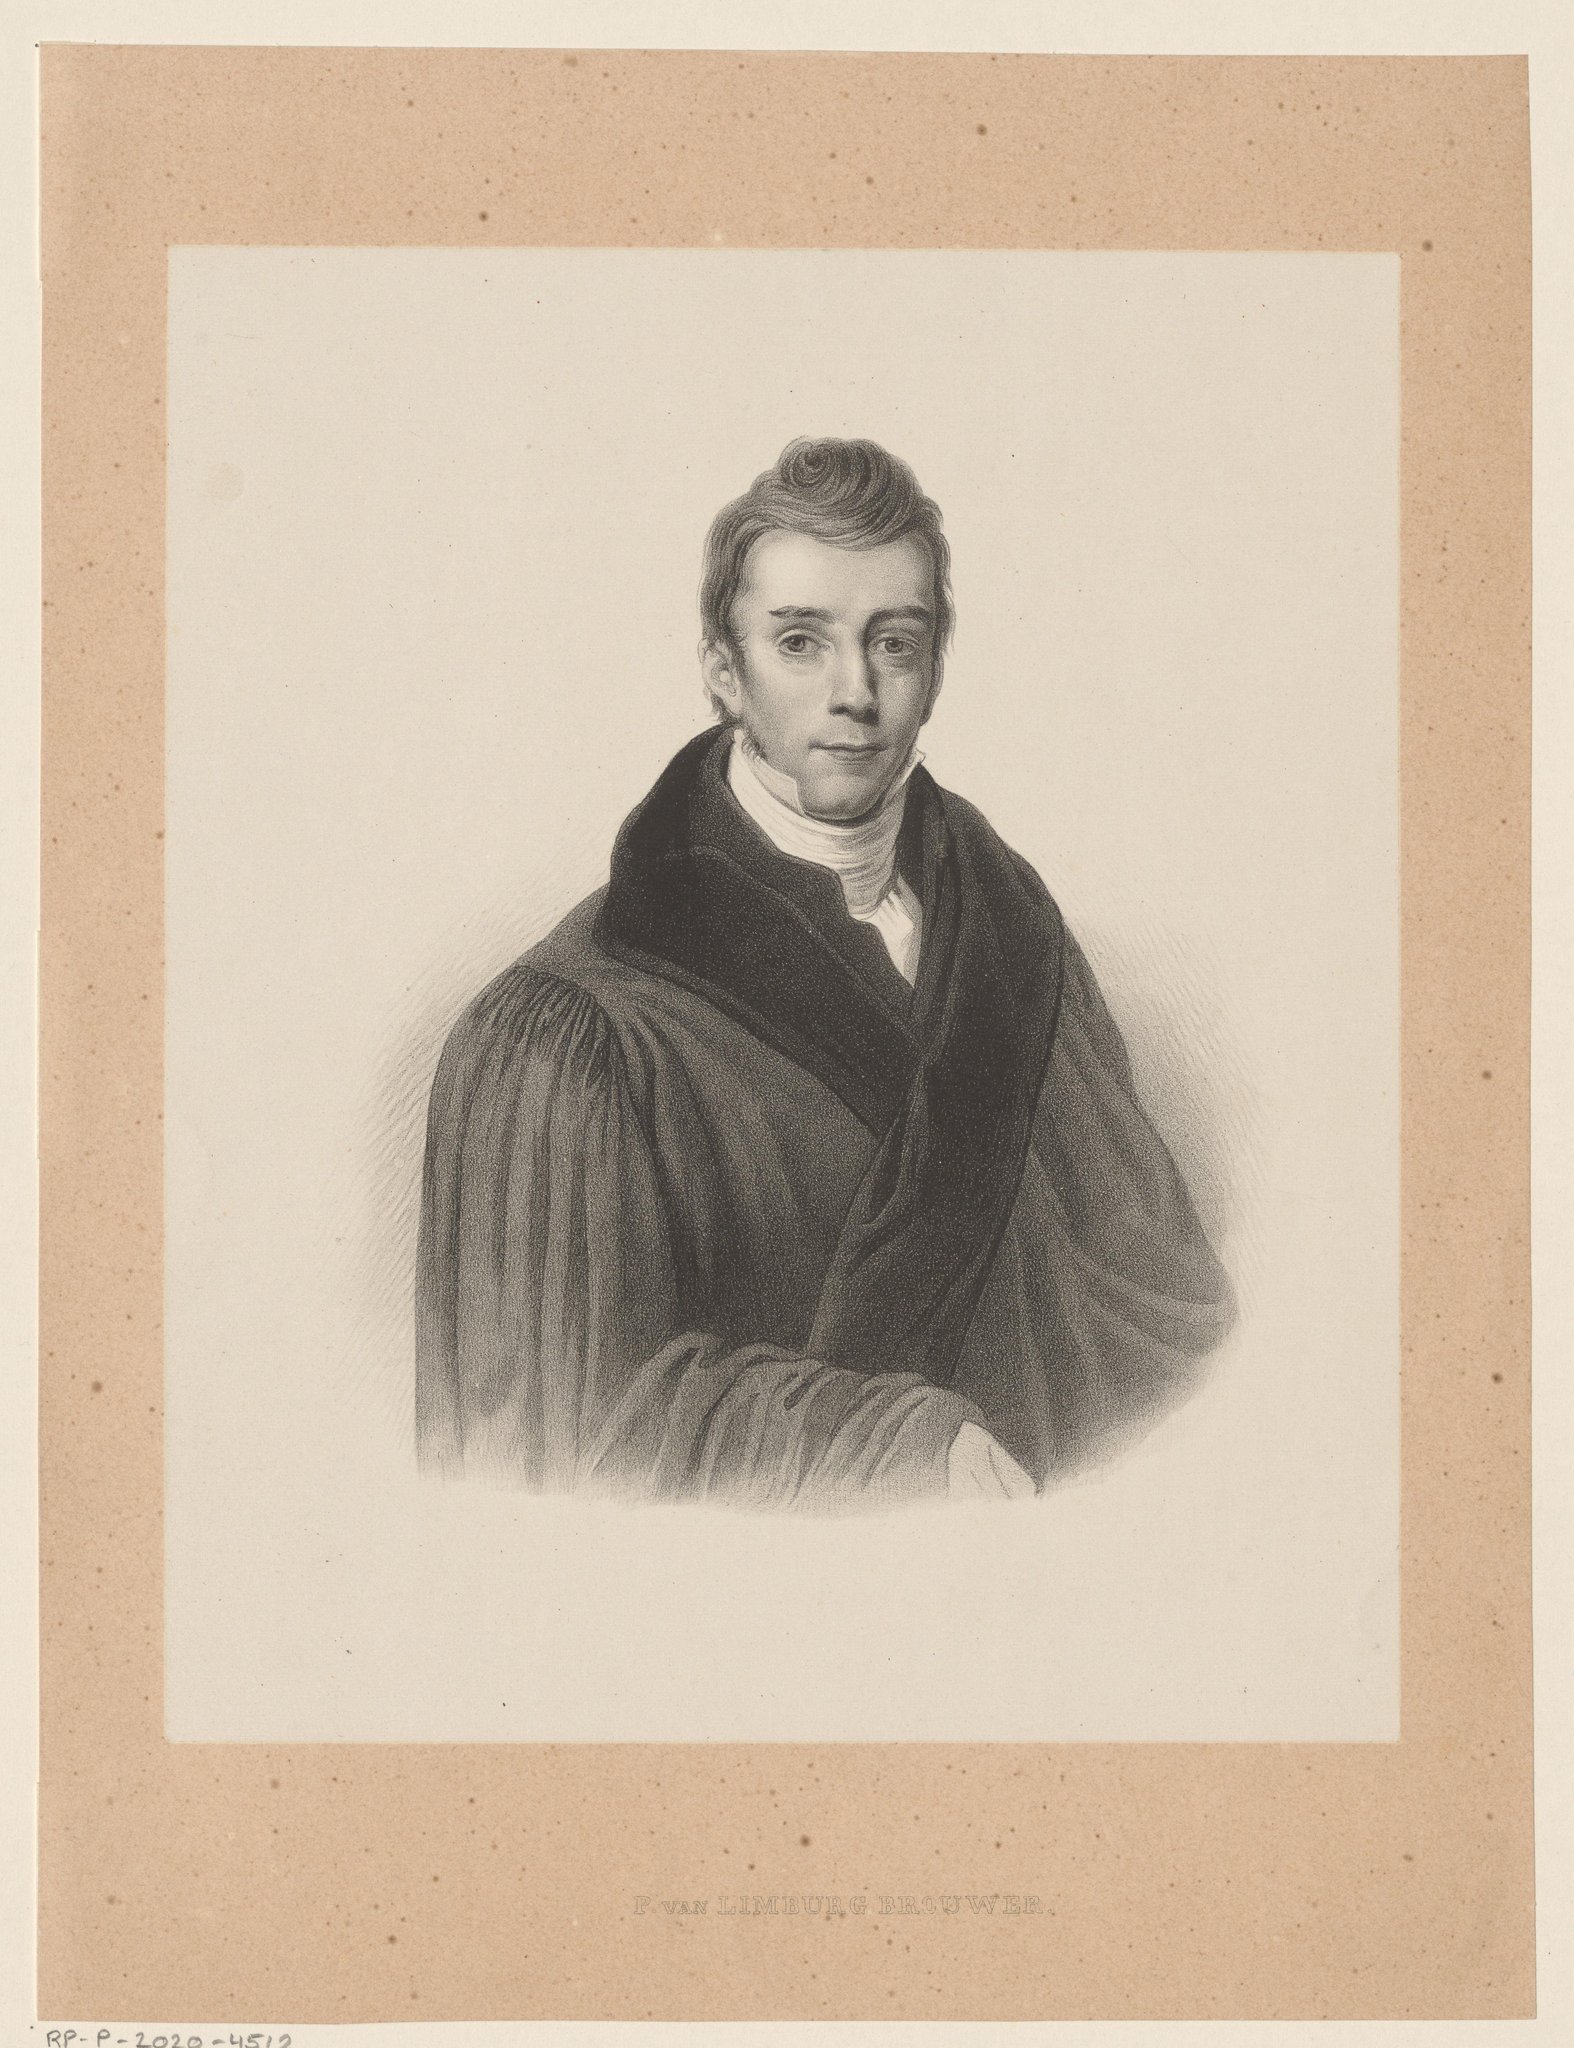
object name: print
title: Portret van Petrus van Limburg Brouwer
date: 1825-1850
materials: paper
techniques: lithograph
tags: dordrecht, scholar, philosopher, historical persons